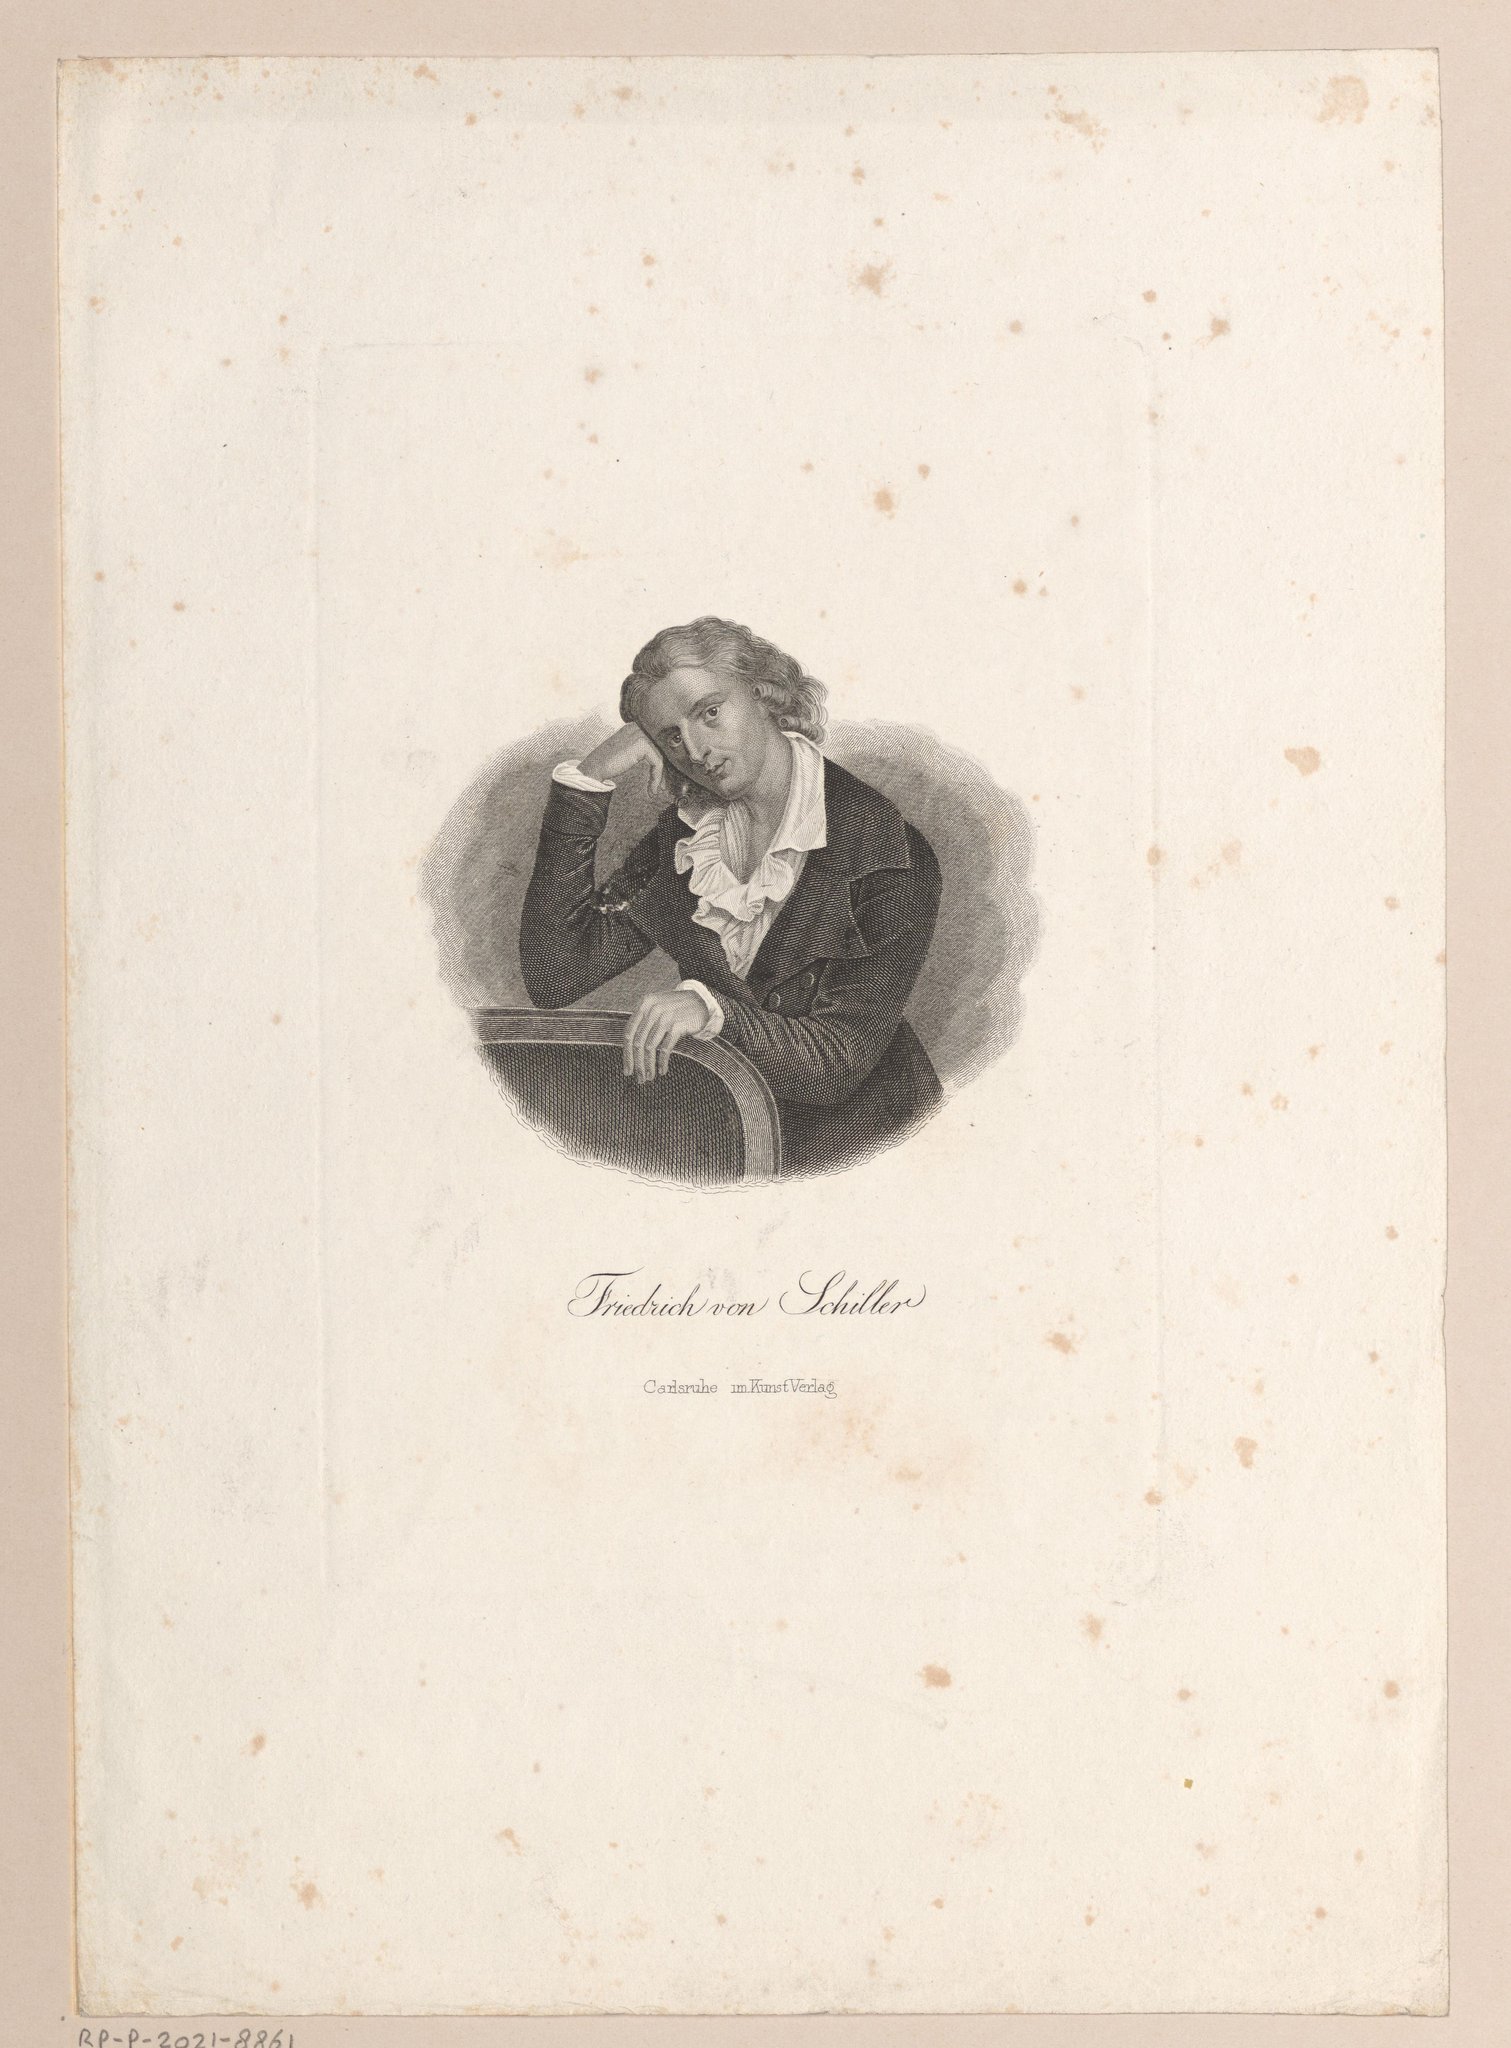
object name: print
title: Portret van Friedrich von Schiller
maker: Anonymous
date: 1850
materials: paper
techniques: engraving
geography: karlsruhe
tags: friedrich von schiller, scholar, philosopher, historical persons, portrait of a writer